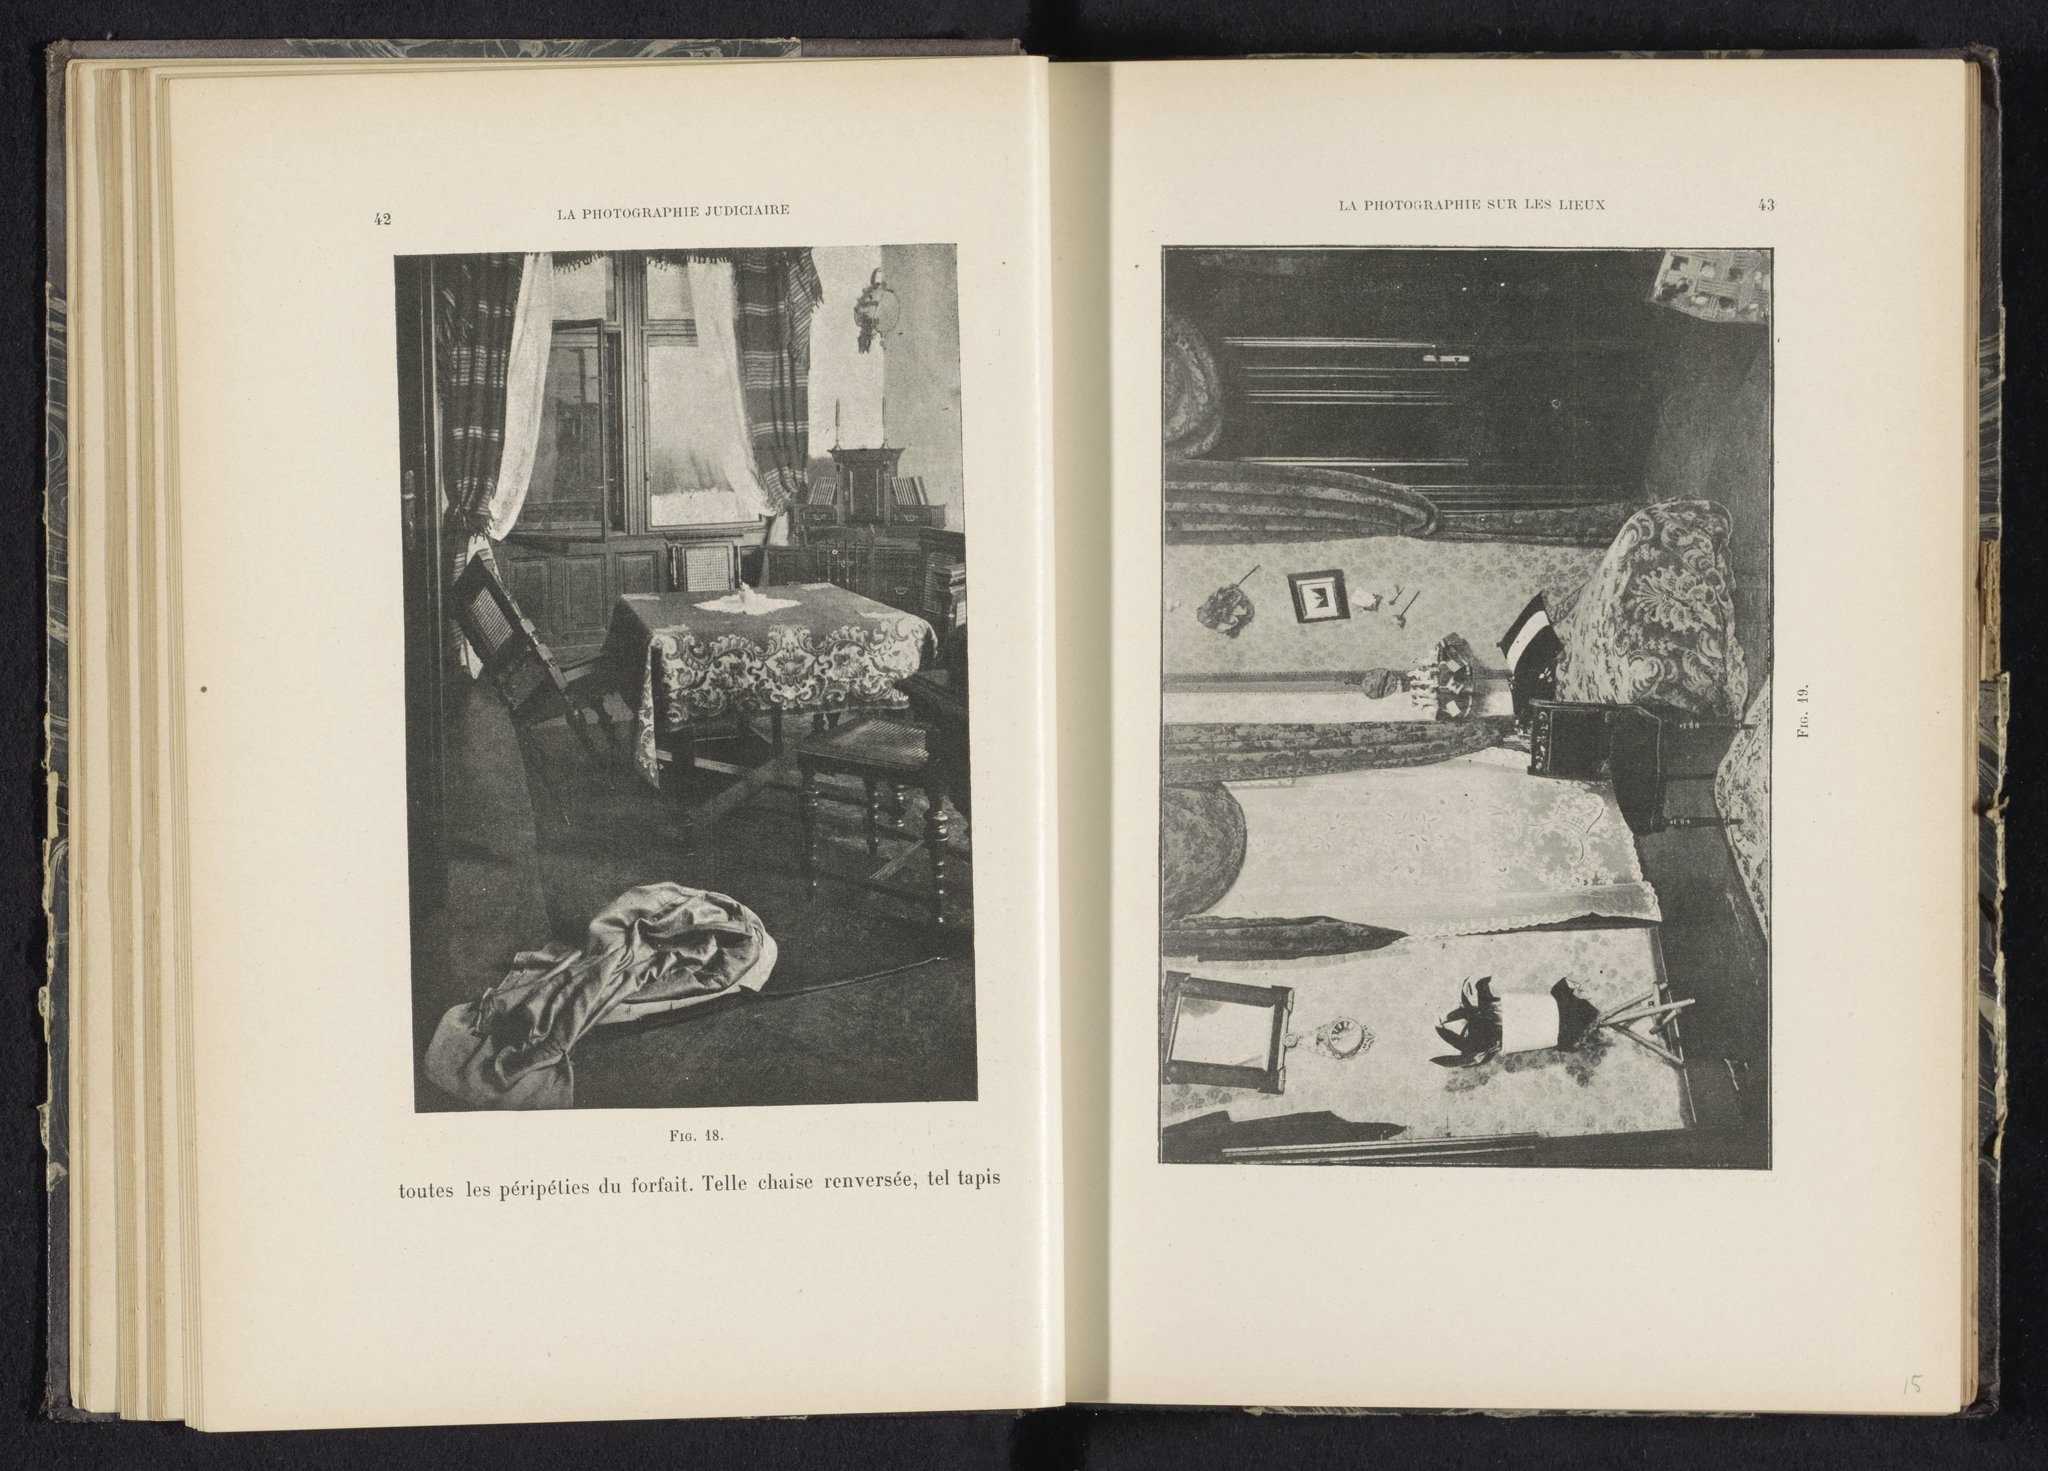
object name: photomechanical print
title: Plaats delict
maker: Anonymous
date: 1893-1903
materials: paper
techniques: autotype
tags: visiting the scene of the crime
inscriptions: number: ‘Fig. 19.’